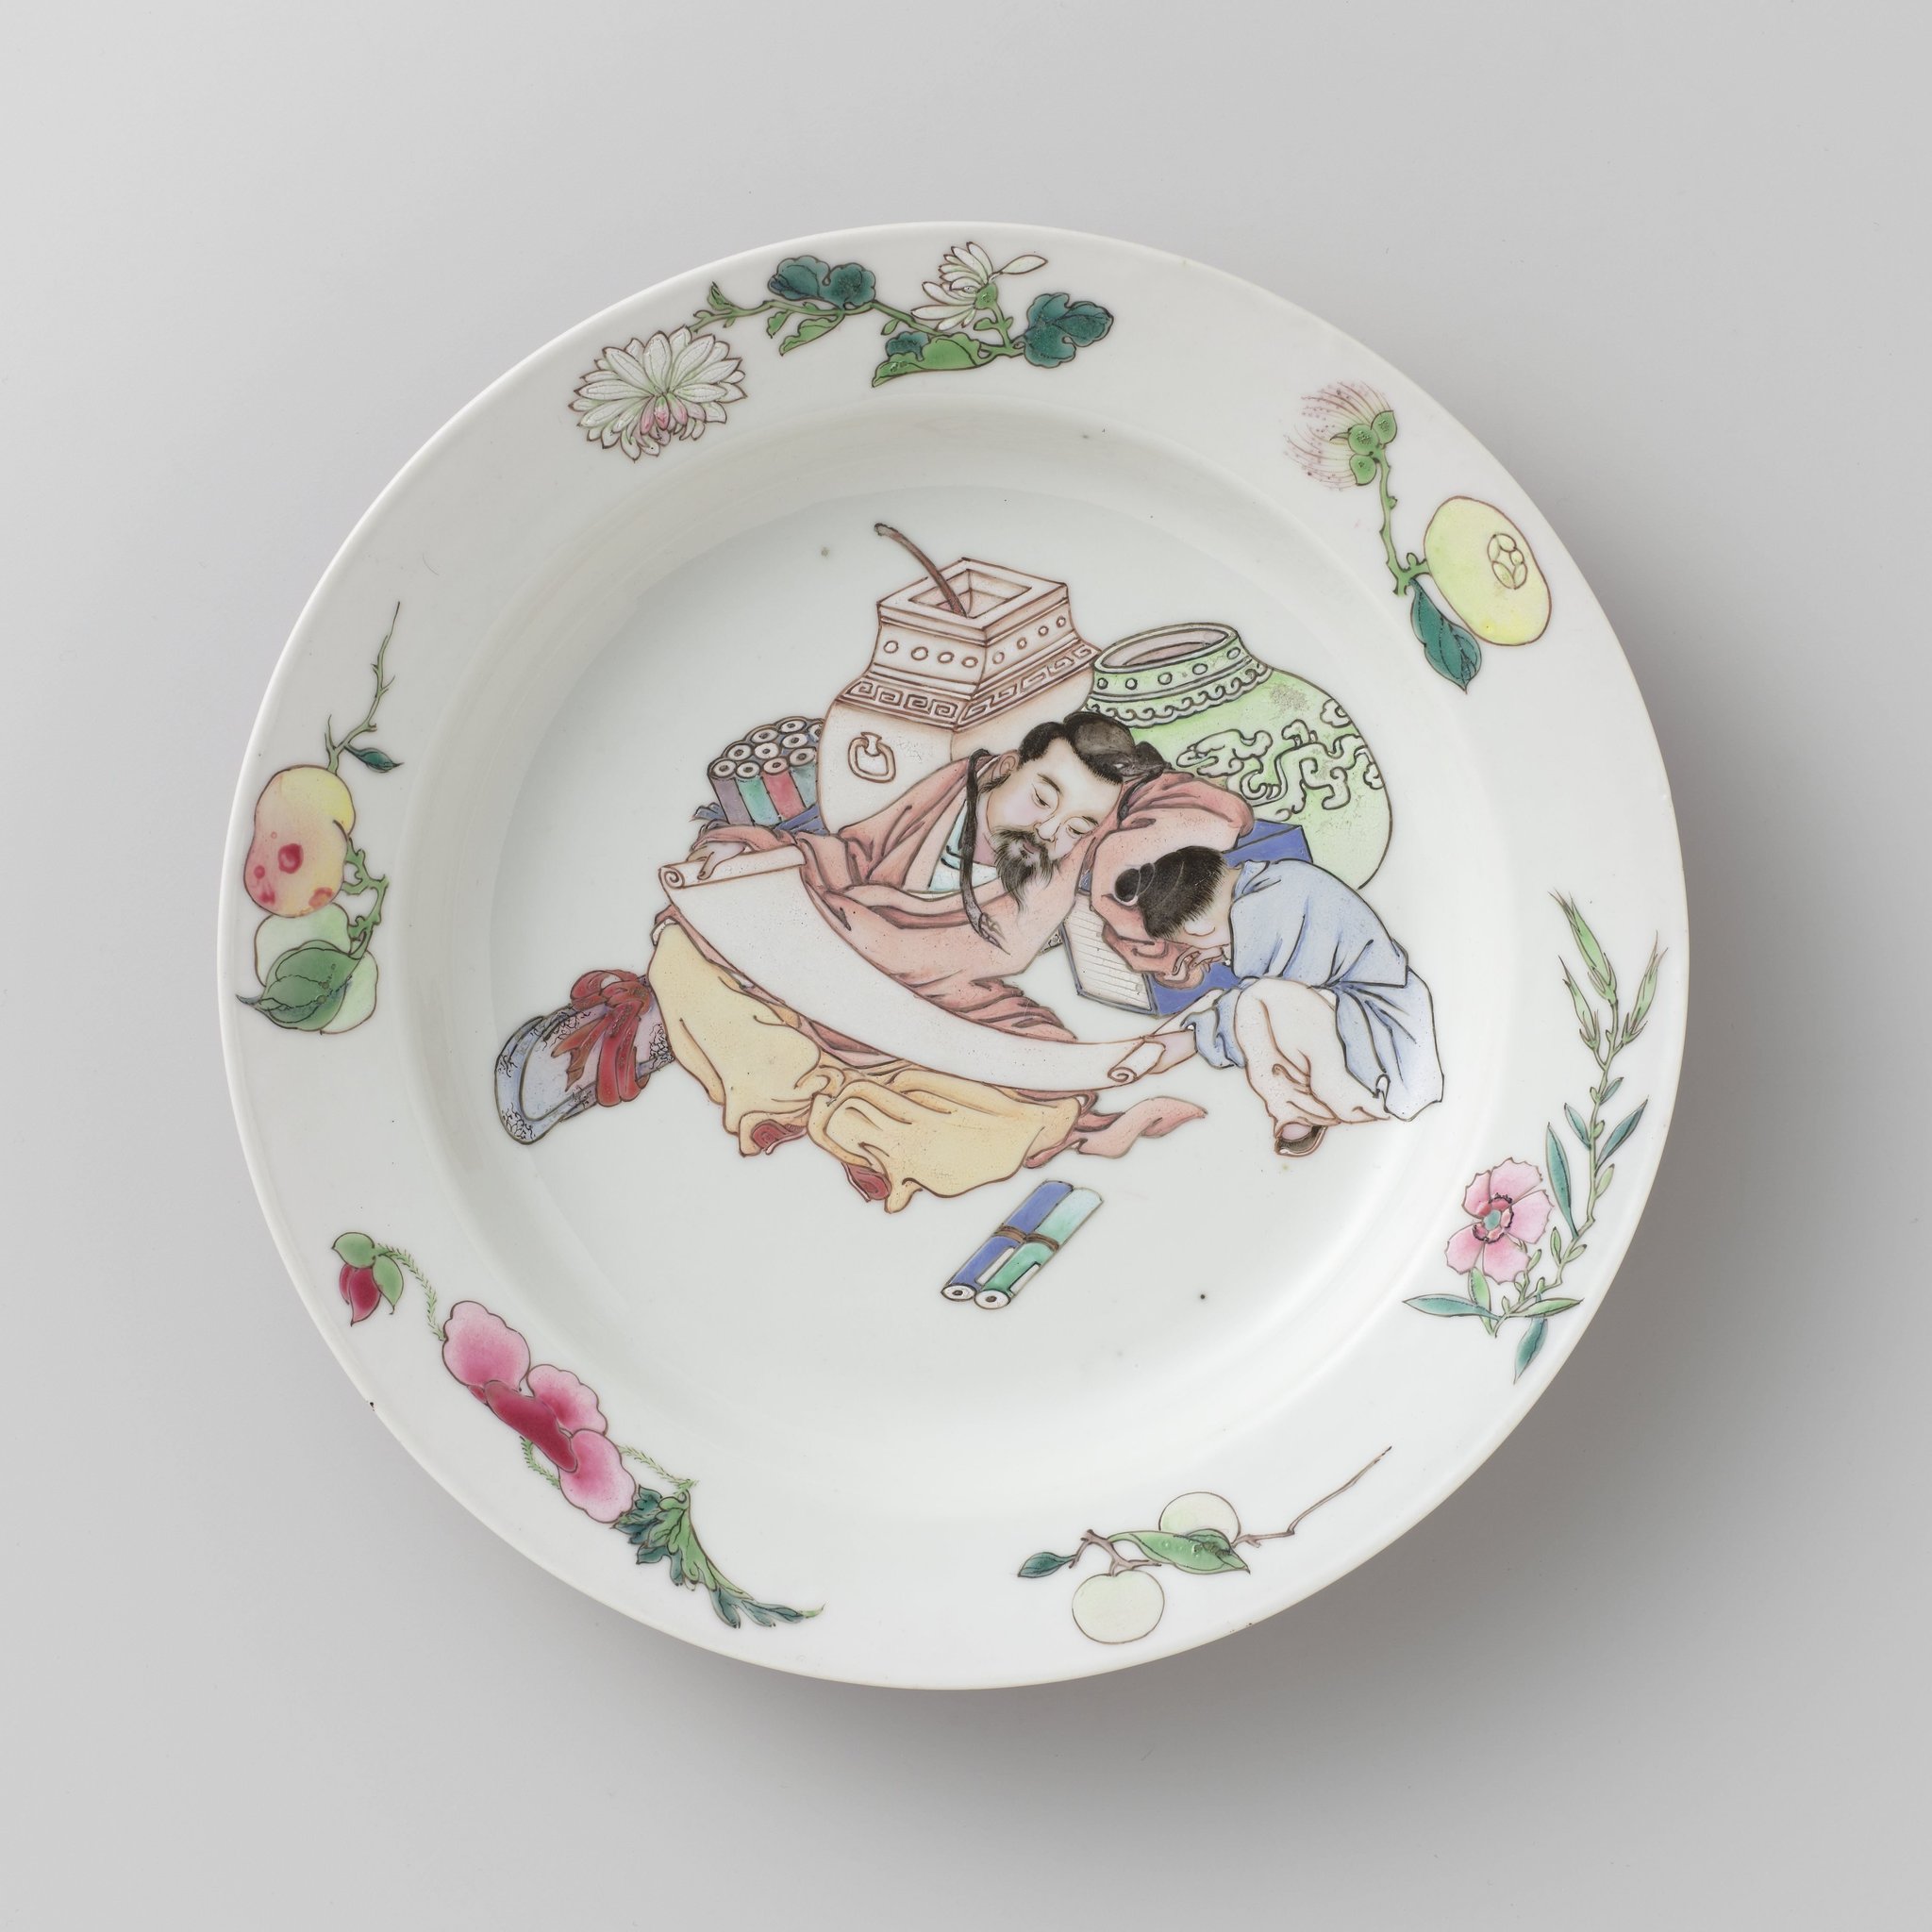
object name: plate dish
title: Plate with an man and a boy examining a scroll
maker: Anonymous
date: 1725-1749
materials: glaze, paint, porcelain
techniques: firing, turning, vitrification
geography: china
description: Bord van dun porselein, bedekt met een roze glazuur en beschilderd op het glazuur in blauw, rood, roze, groen, geel en zwart. Op het plat twee zittende Chinese mannen een rol onderzoekend, om hen heen verschillende geluksvoorwerpen; de rand met bloem- en fruittakken. De achterzijde is bedekt met een roze glazuur. Famile rose met een ruby back.